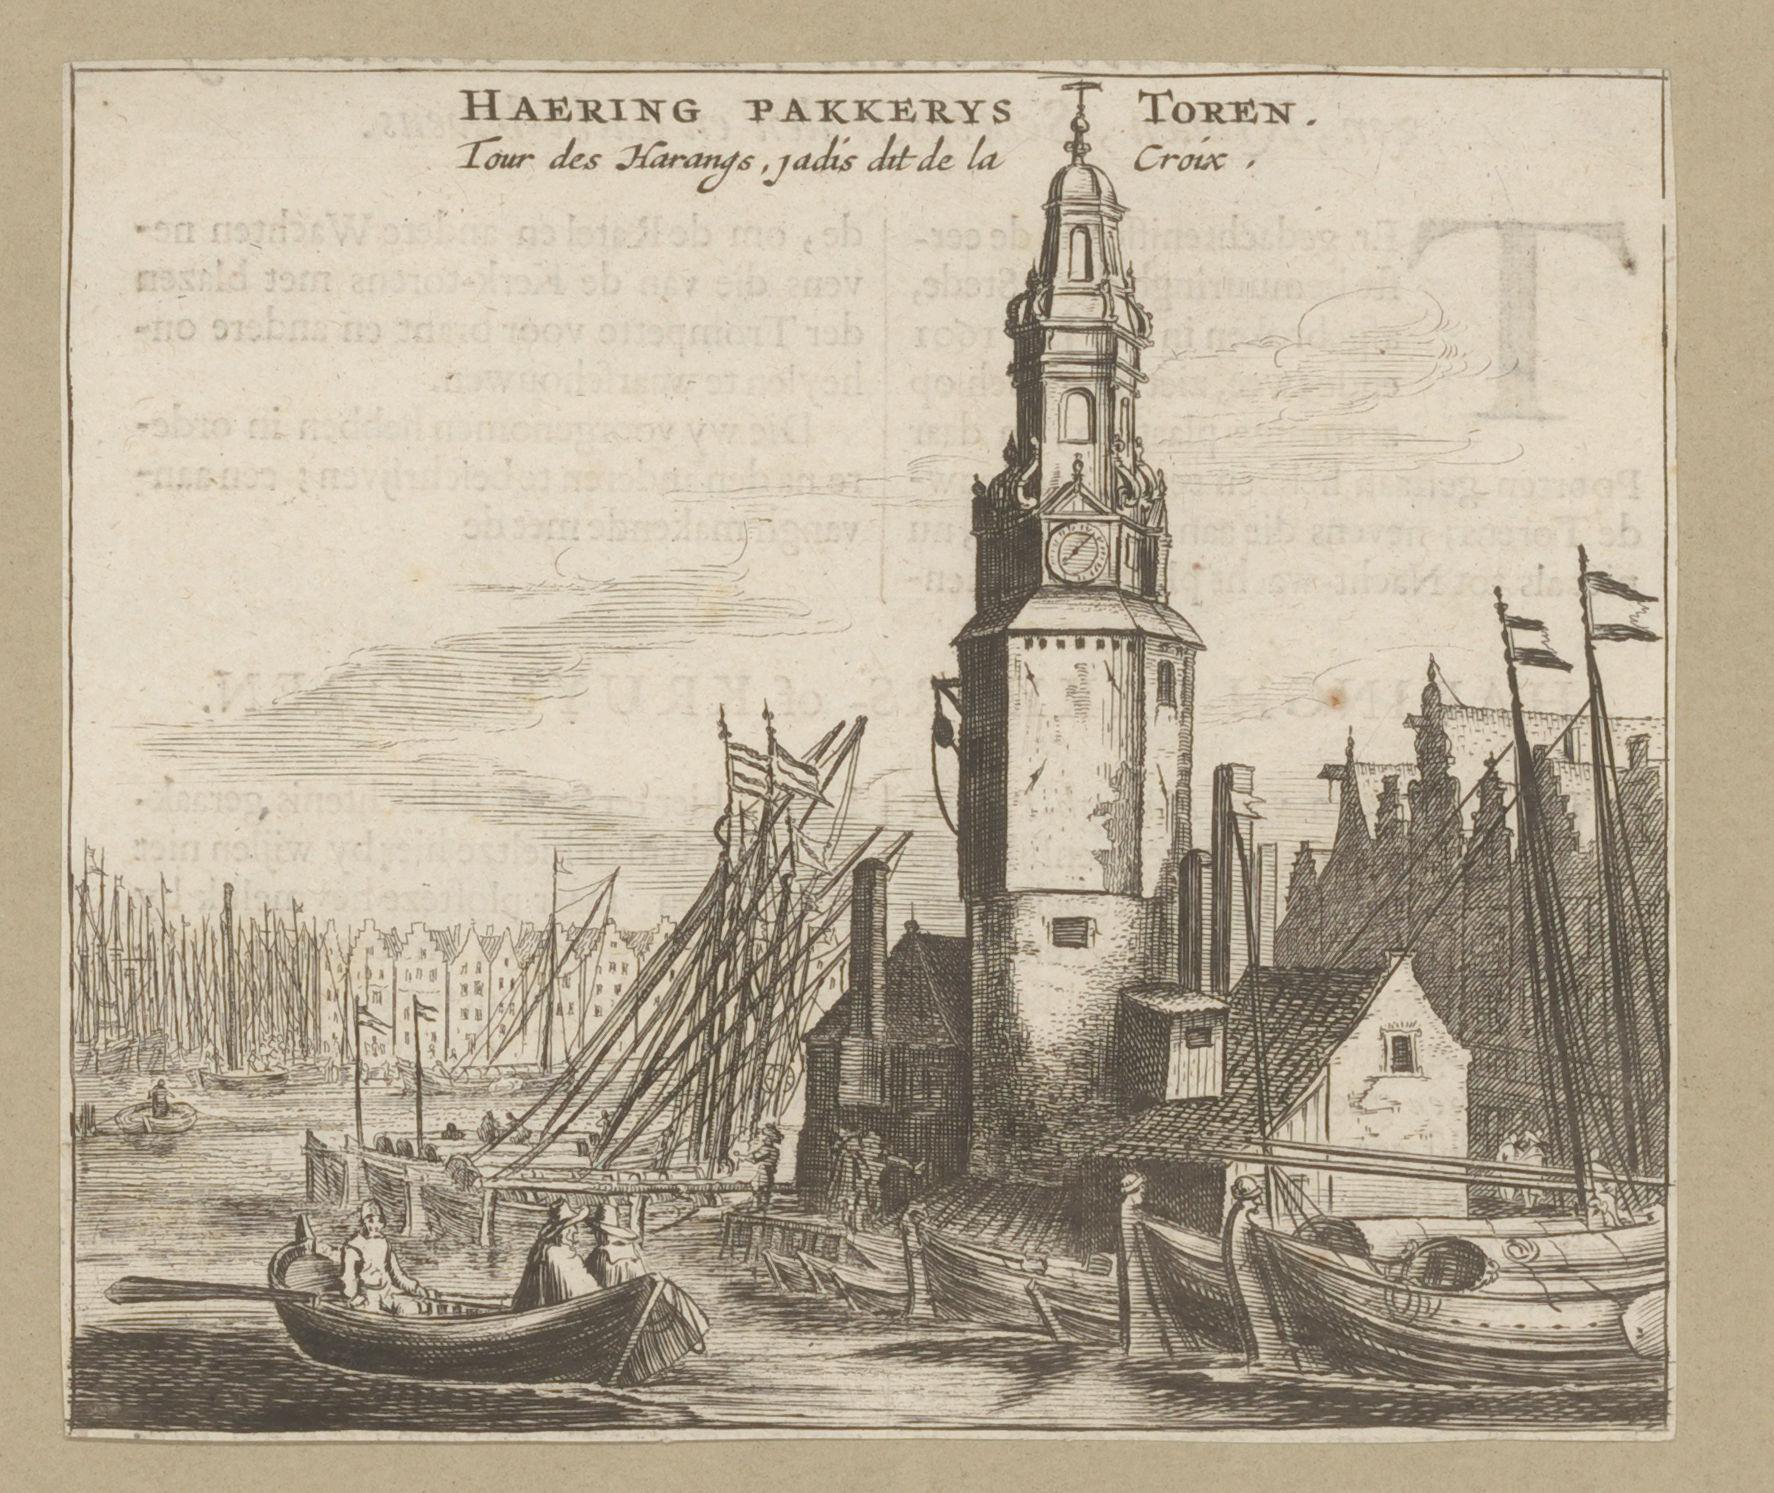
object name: print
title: Gezicht op de Haringpakkerstoren te Amsterdam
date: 1665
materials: paper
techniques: engraving, etching, letterpress printing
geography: amsterdam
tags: tower, clock tower ~ monumental adornment, rowing-boat, canoe, etc., canals, waters (in city)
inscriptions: collector's mark: Lugt 1641b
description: Prent uit: Domselaer, Tobias en Isaac Commelin. Beschryvinge van Amsterdam (…). 6 dln. Amsterdam: Marcus Willemsz. Doornick, 1665, dl. 4, p. 256.